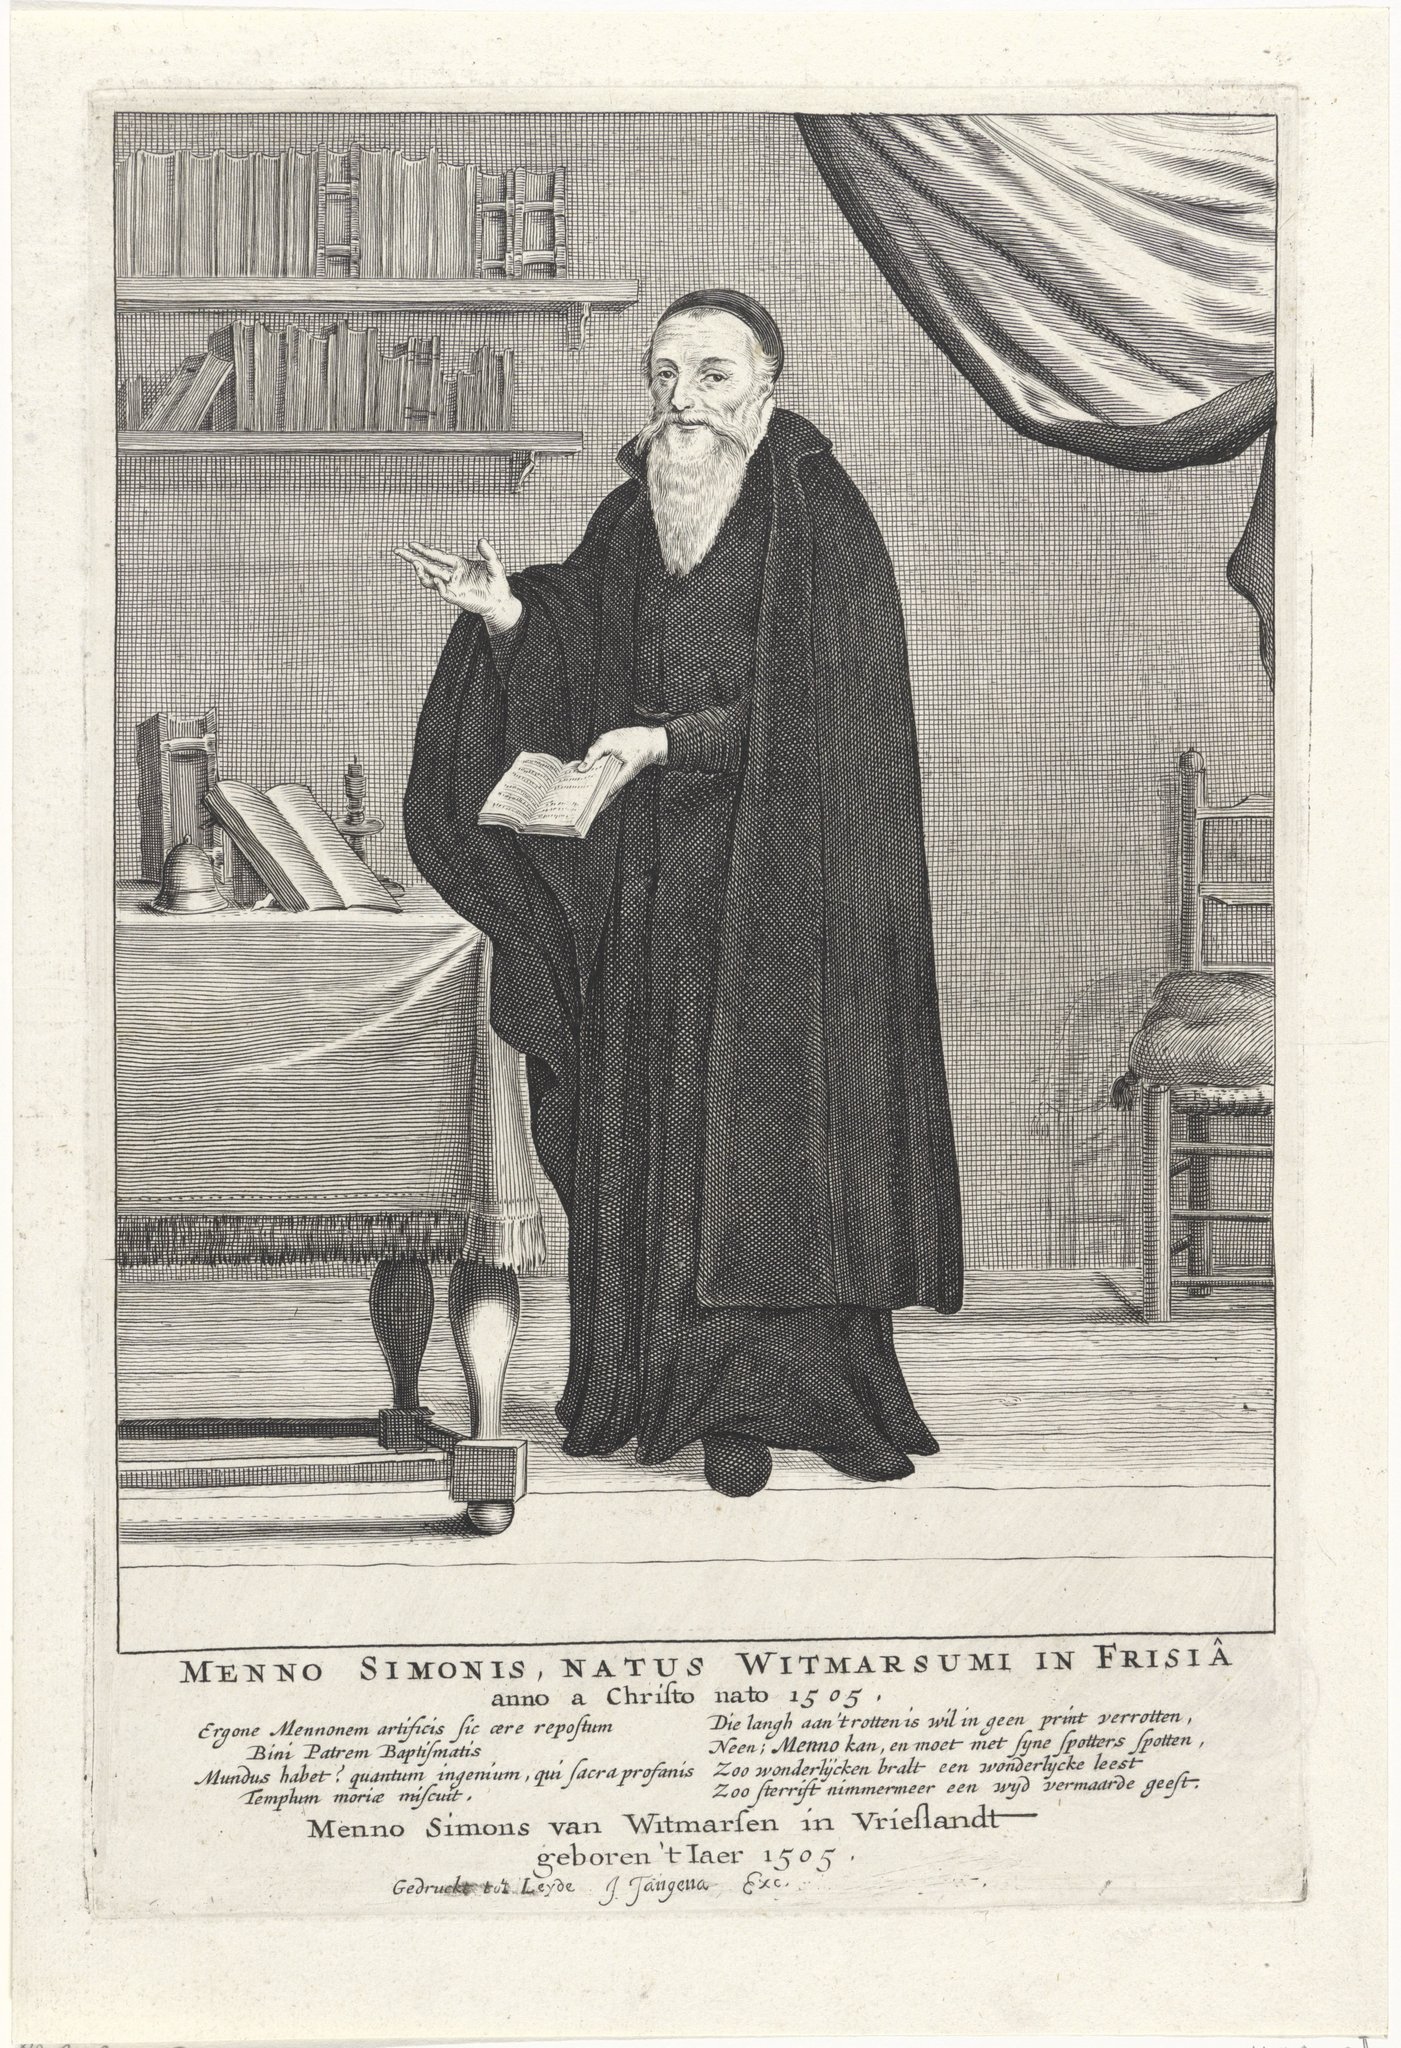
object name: print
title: Portret van Menno Simons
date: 1687-1698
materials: paper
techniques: engraving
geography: leiden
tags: scholar in his study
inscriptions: collector's mark: Lugt 240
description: Portret van Menno Simons, leider van de Mennonieten, staande in zijn studeerkamer. Hij houdt een opengeslagen boek in de hand. Aan de wand boekenplanken. Links een tafel met daarop boeken, een schel en een kaars. Onderaan in de marge een vierregelig vers in het Latijn en in het Nederlands.